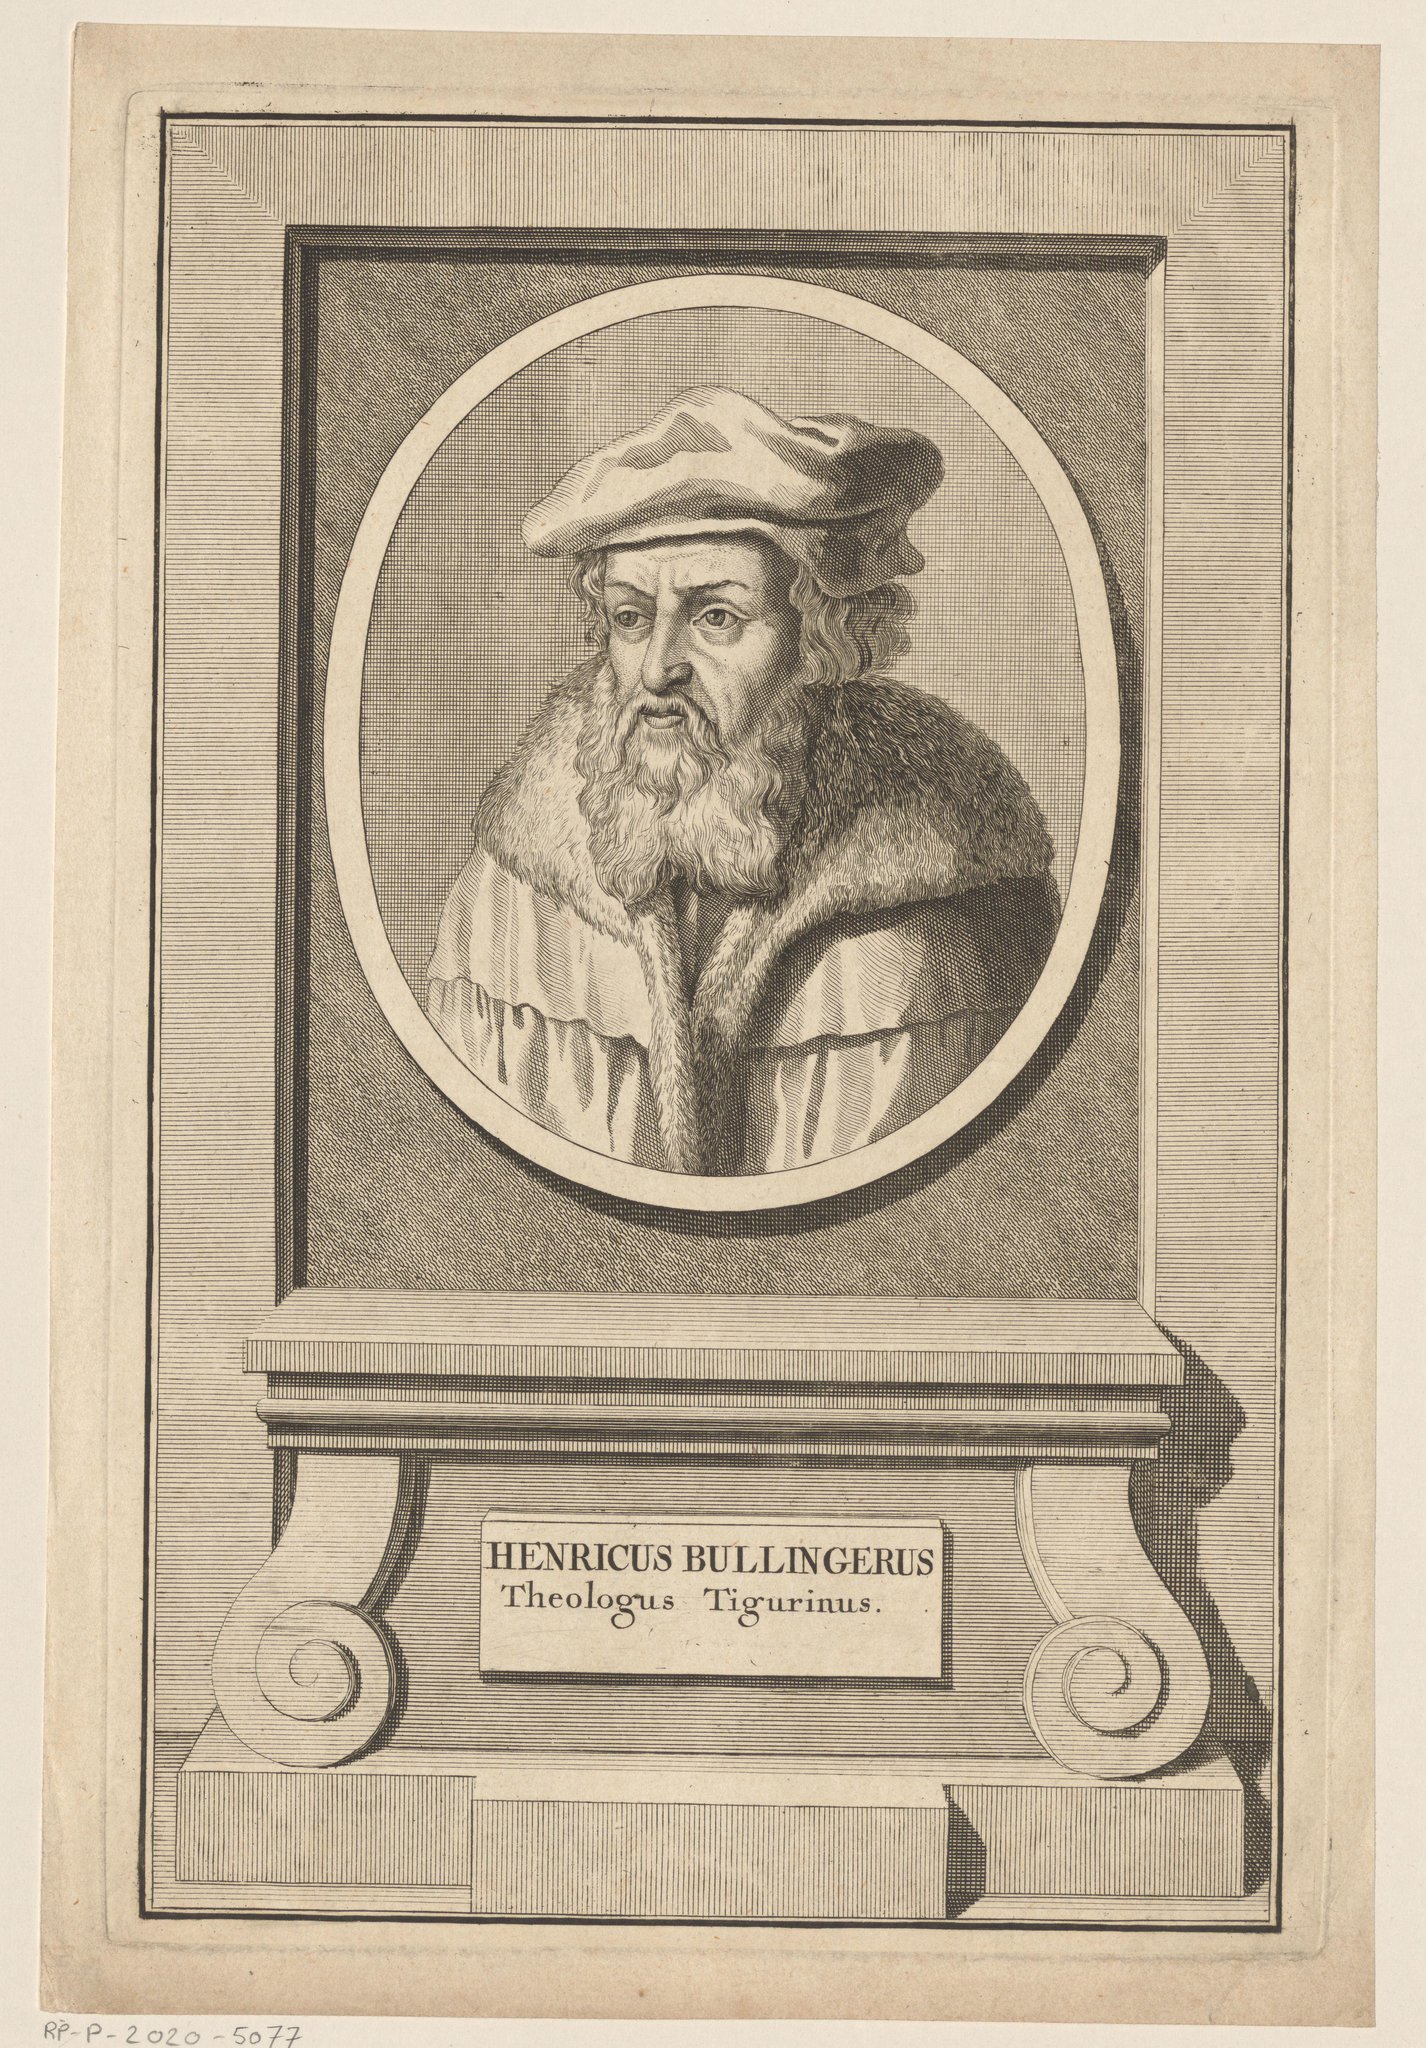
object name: print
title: Portret van Johann Heinrich Bullinger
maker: Anonymous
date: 1700-1749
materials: paper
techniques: engraving, etching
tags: theologian, historical persons